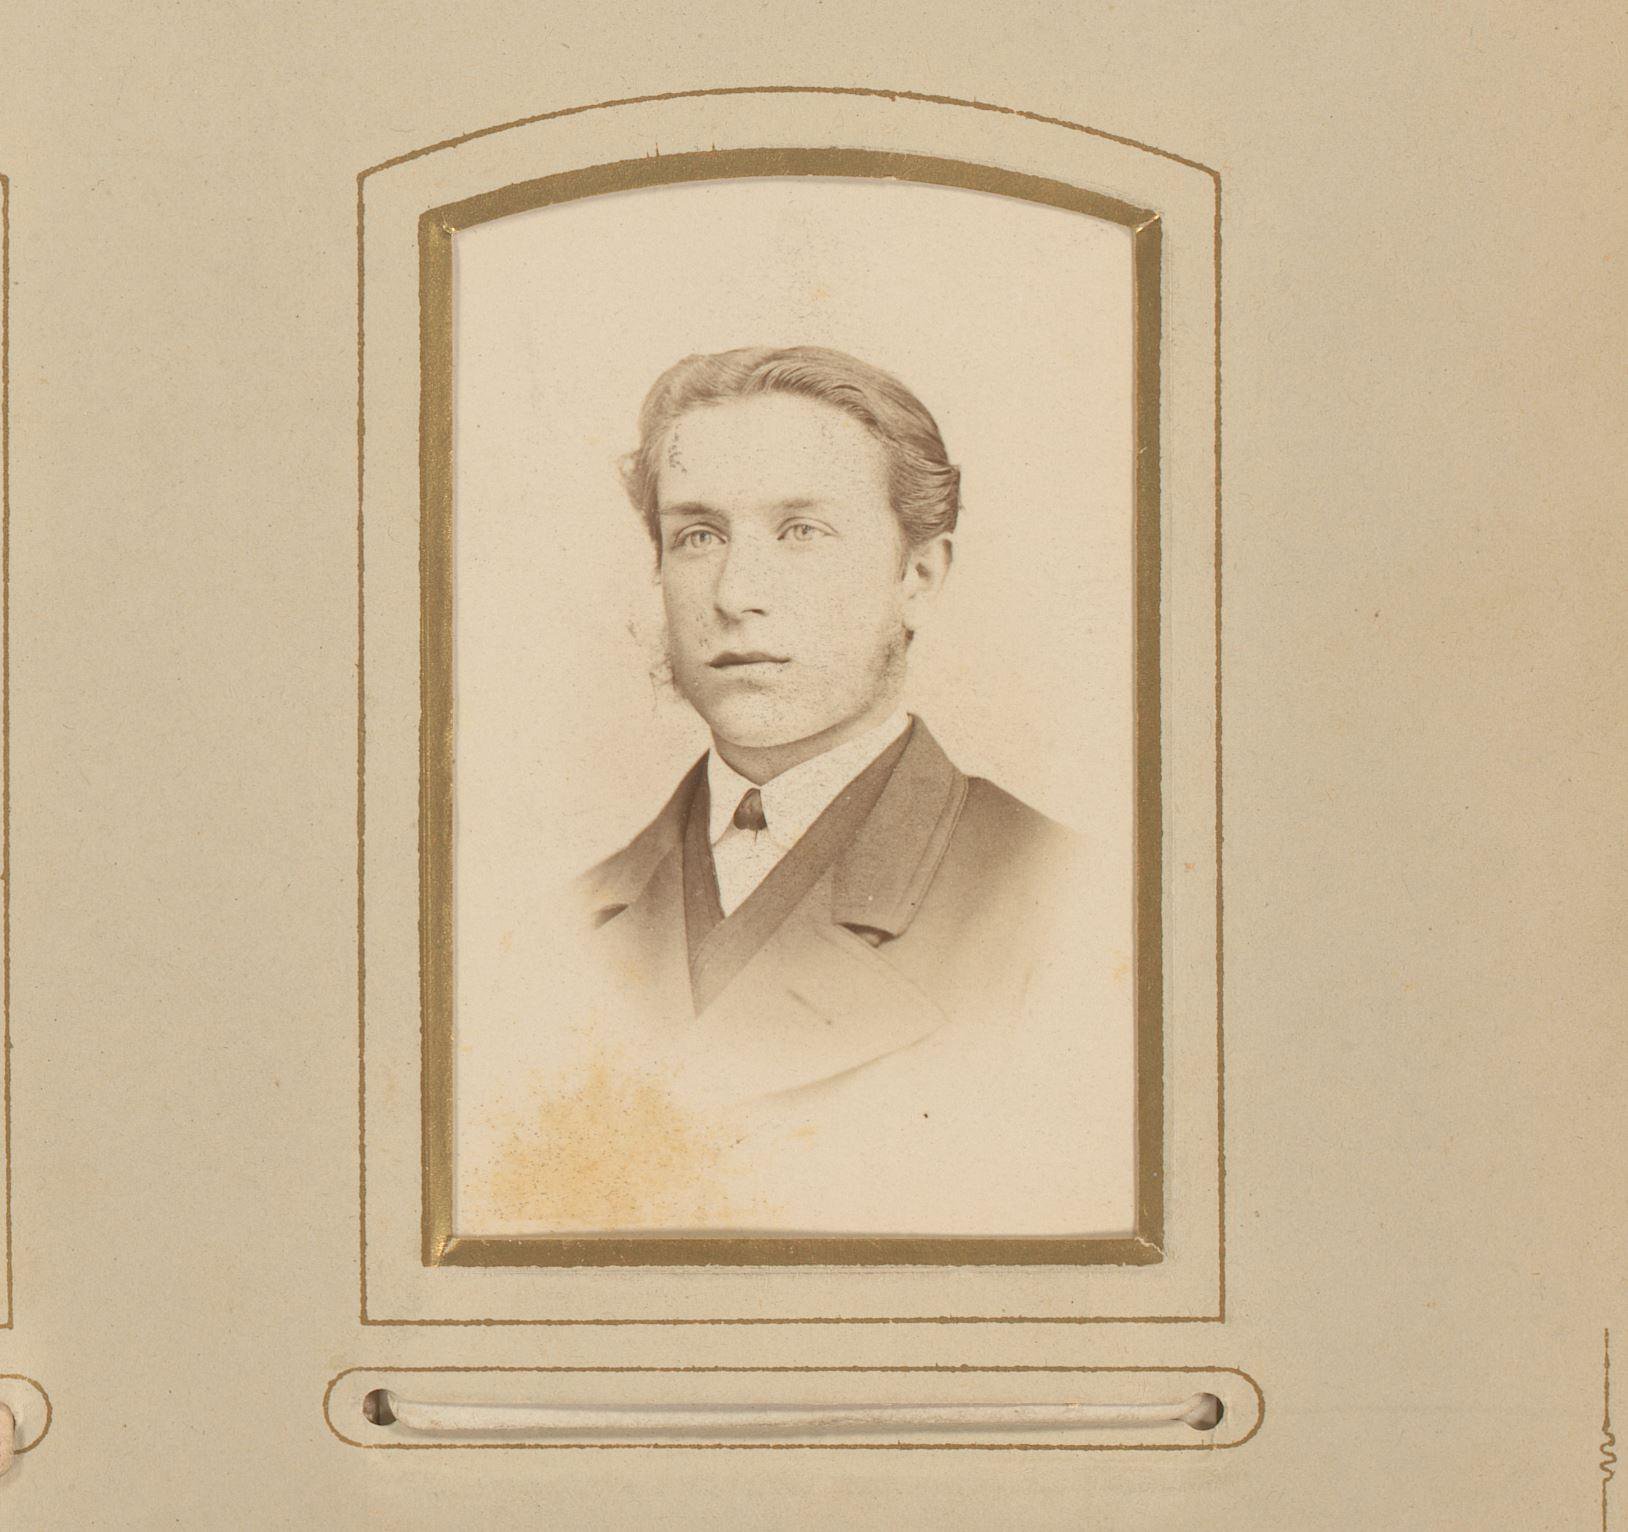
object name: photograph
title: Portret van een jonge man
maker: c.w. hensgen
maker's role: fotograaf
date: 1807-1870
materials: cardboard, photographic support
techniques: albumen print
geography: eisenach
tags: historical persons, youth, adolescent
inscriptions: inscription: ‘C.W. Hensgen/ EISENACH/ Obere Querstrasse/ B. 78.’, date: ‘Juli 1870.’